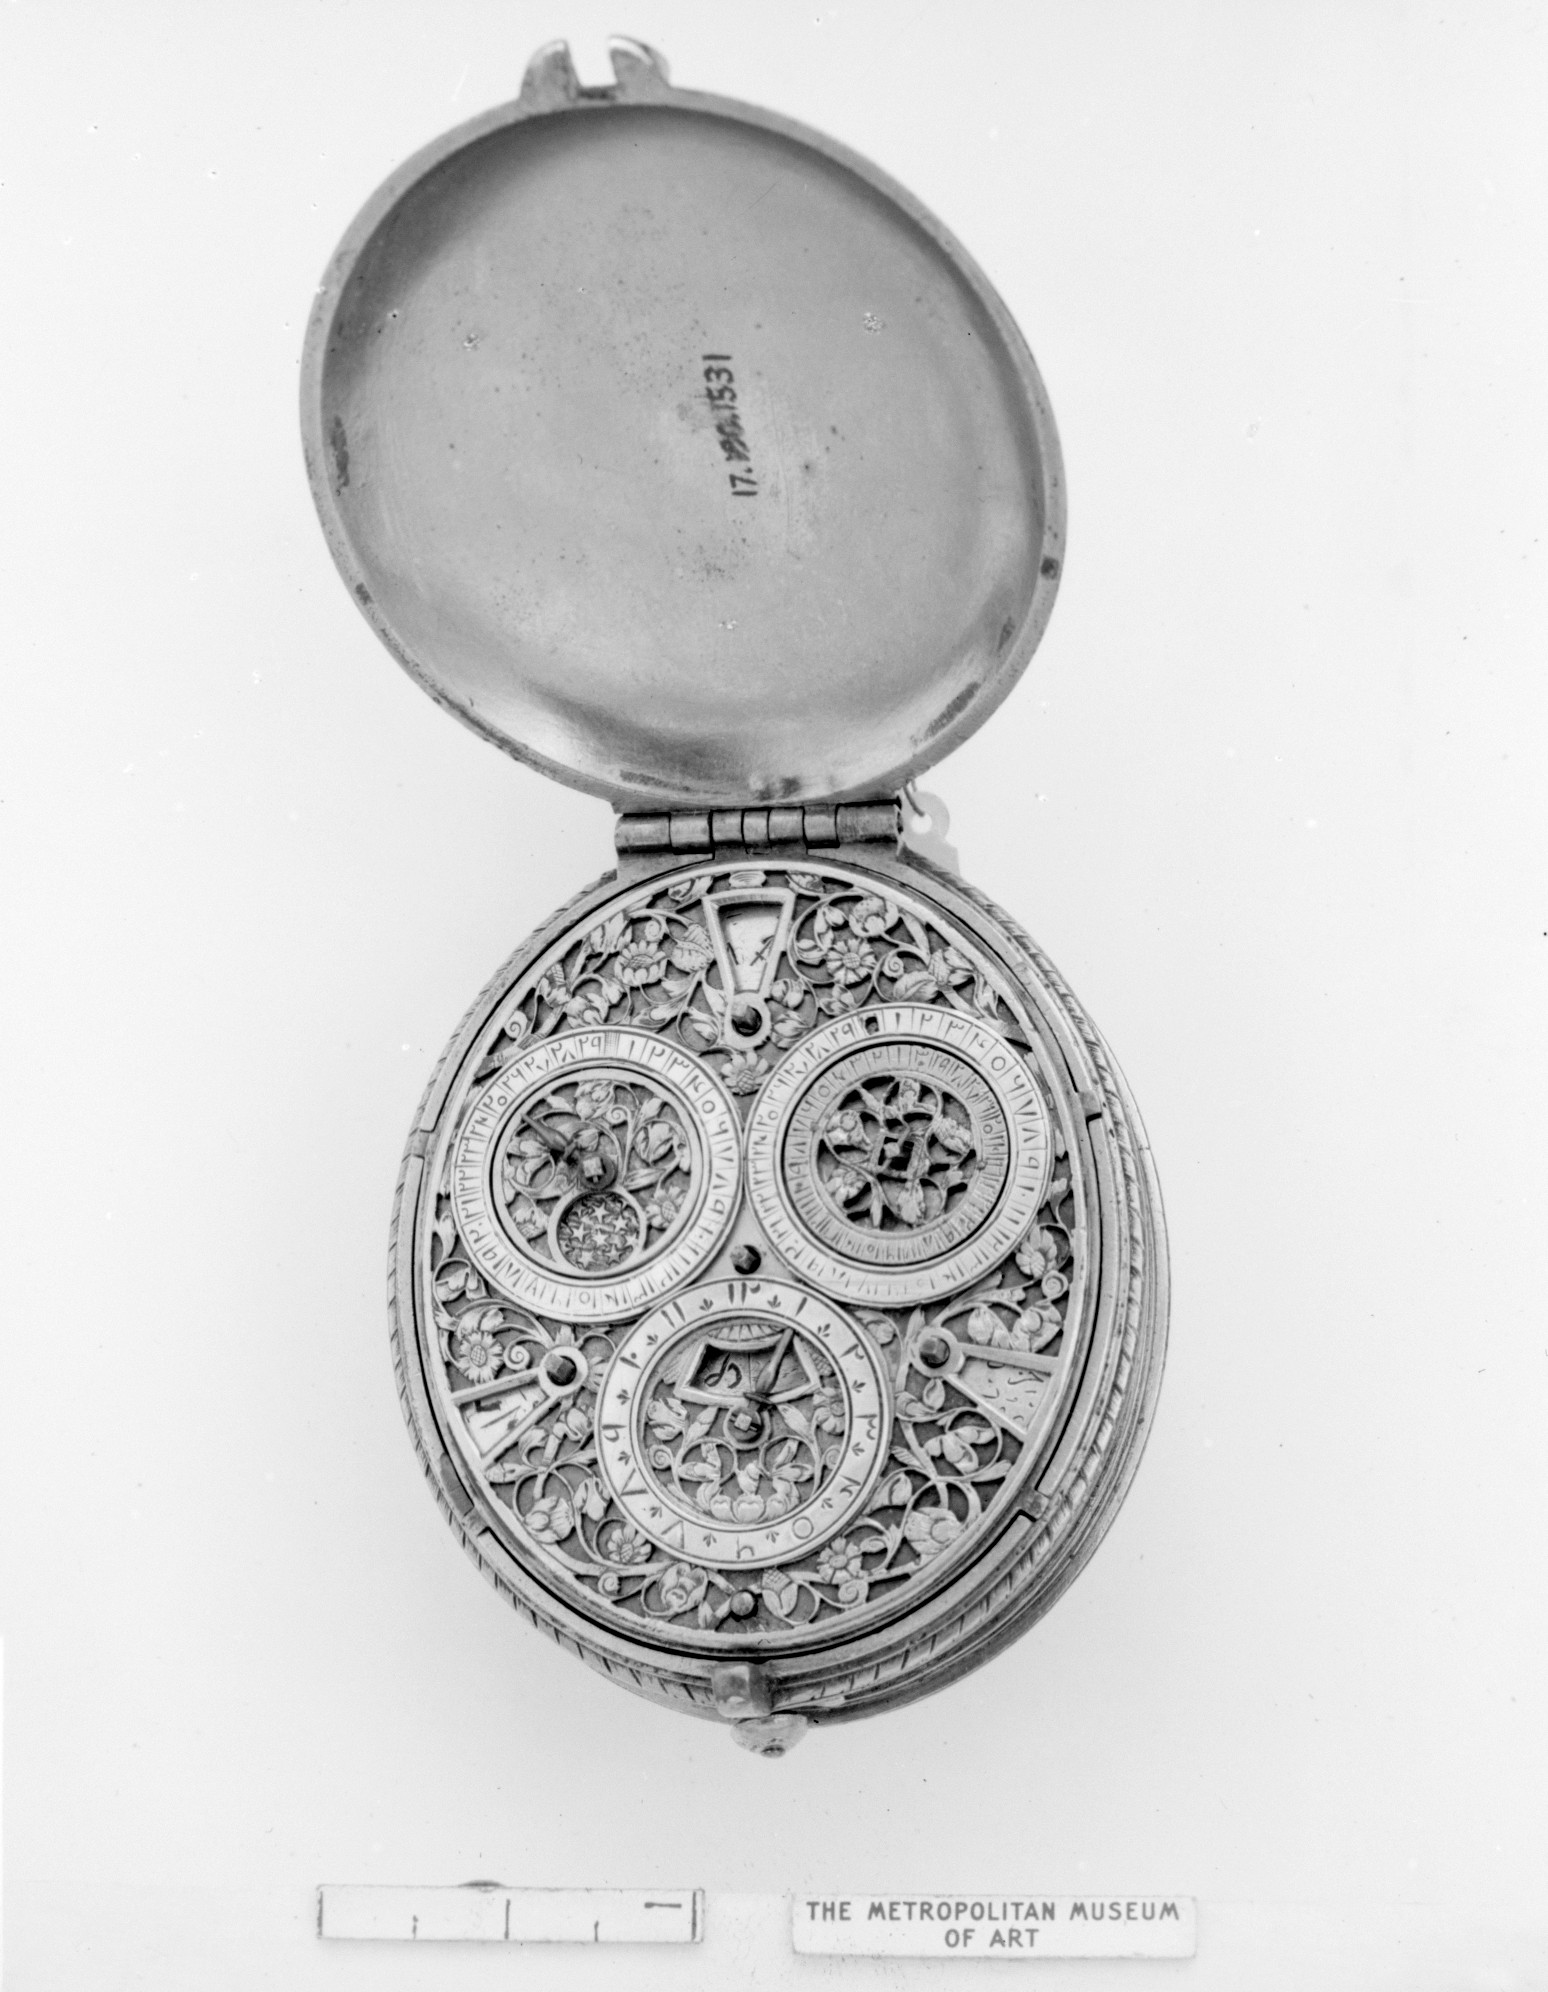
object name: watch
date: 1620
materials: gilt, metal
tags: flowers